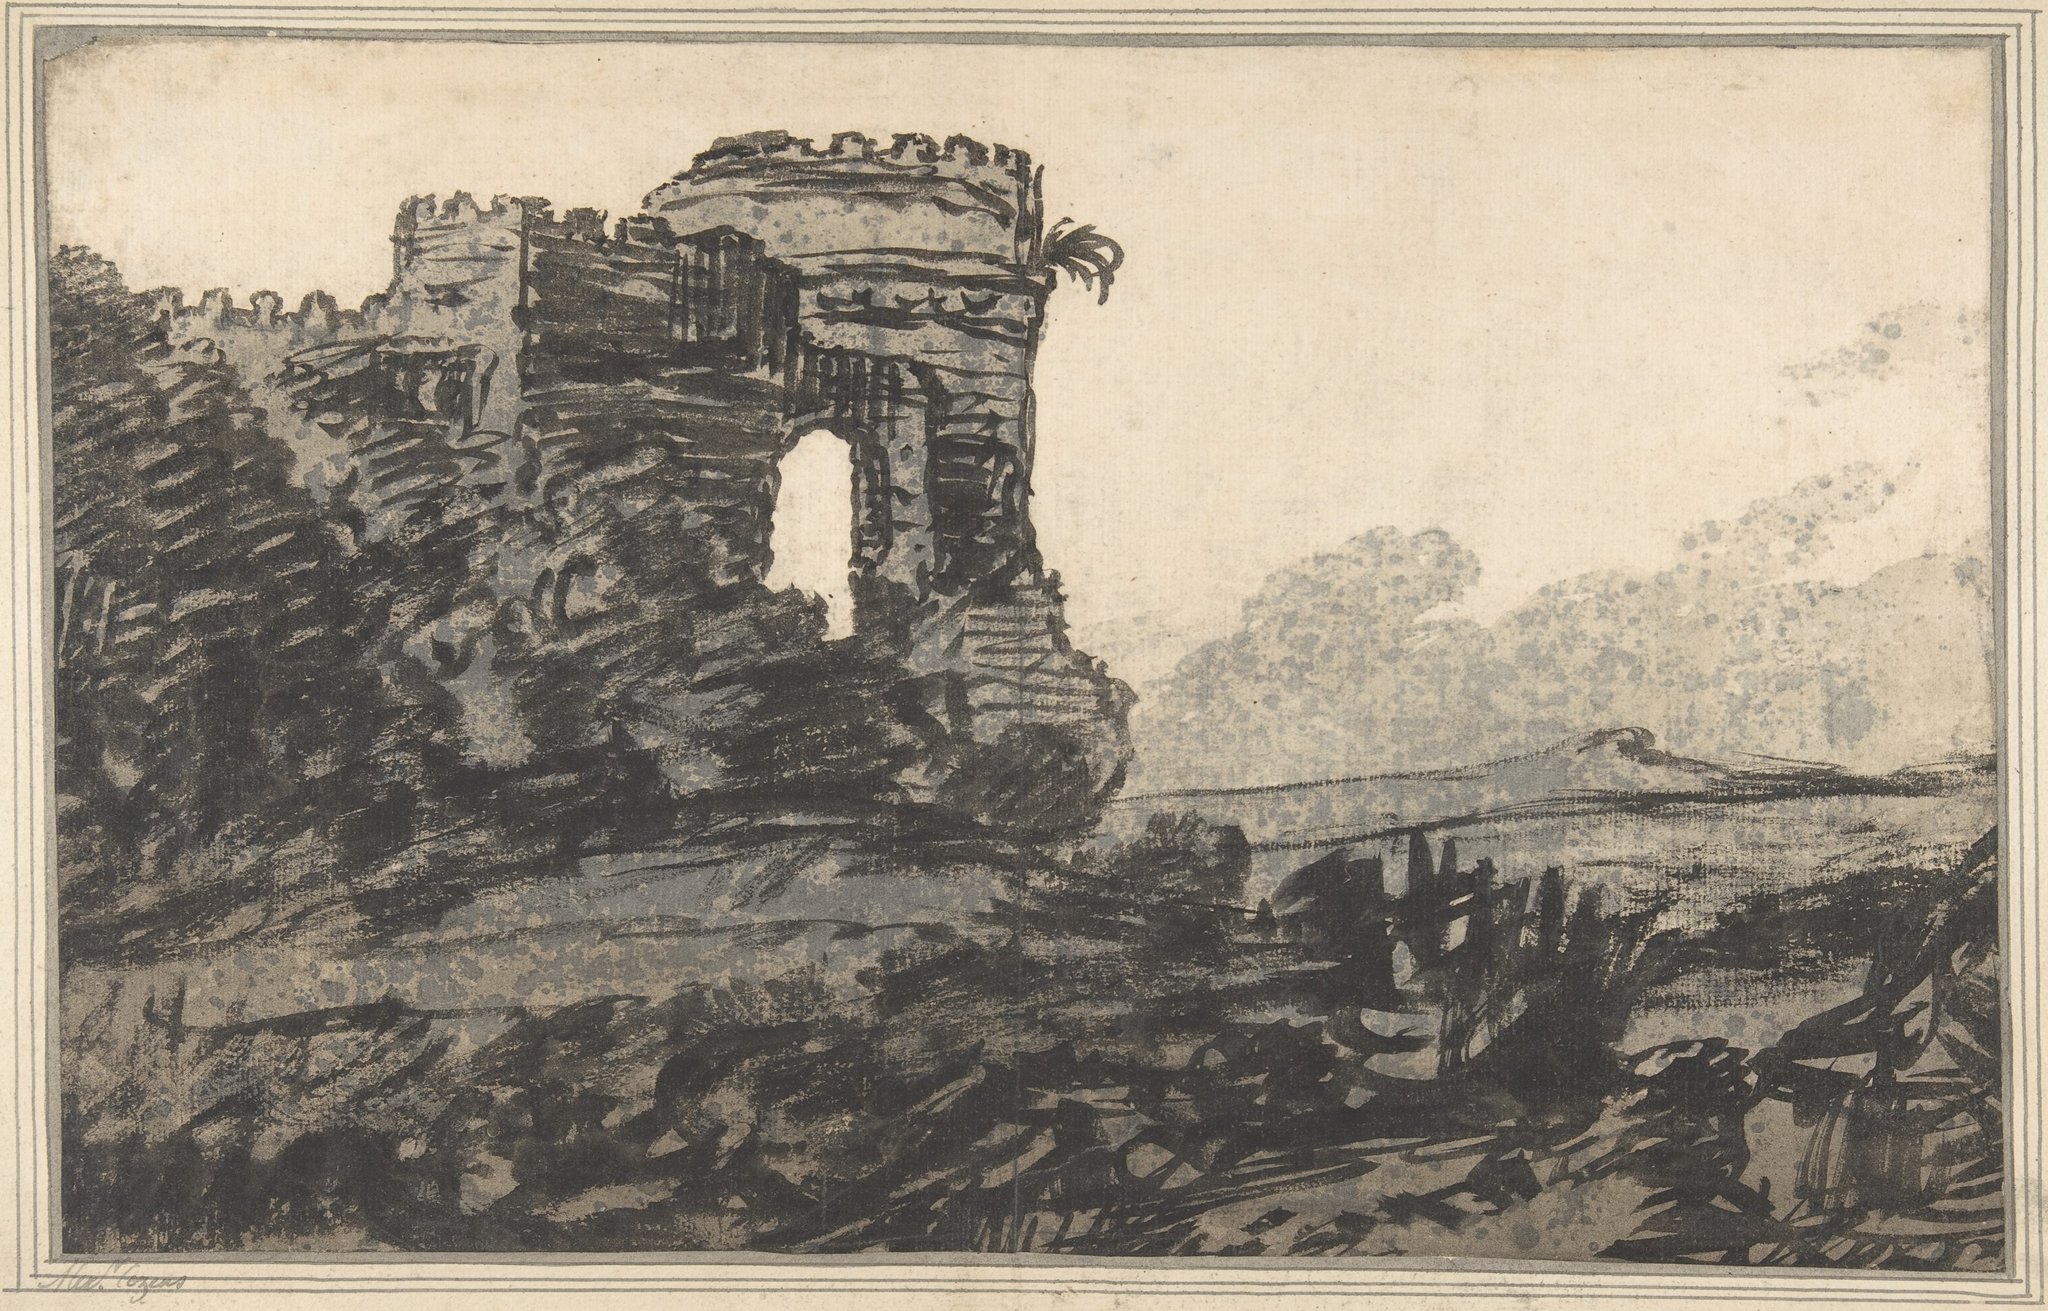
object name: drawing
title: Ruined Castle and Trees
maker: alexander cozens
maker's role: artist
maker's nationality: british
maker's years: 1717-1786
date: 1762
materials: graphite, ink, paper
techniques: brush, wash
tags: castles,ruins,trees